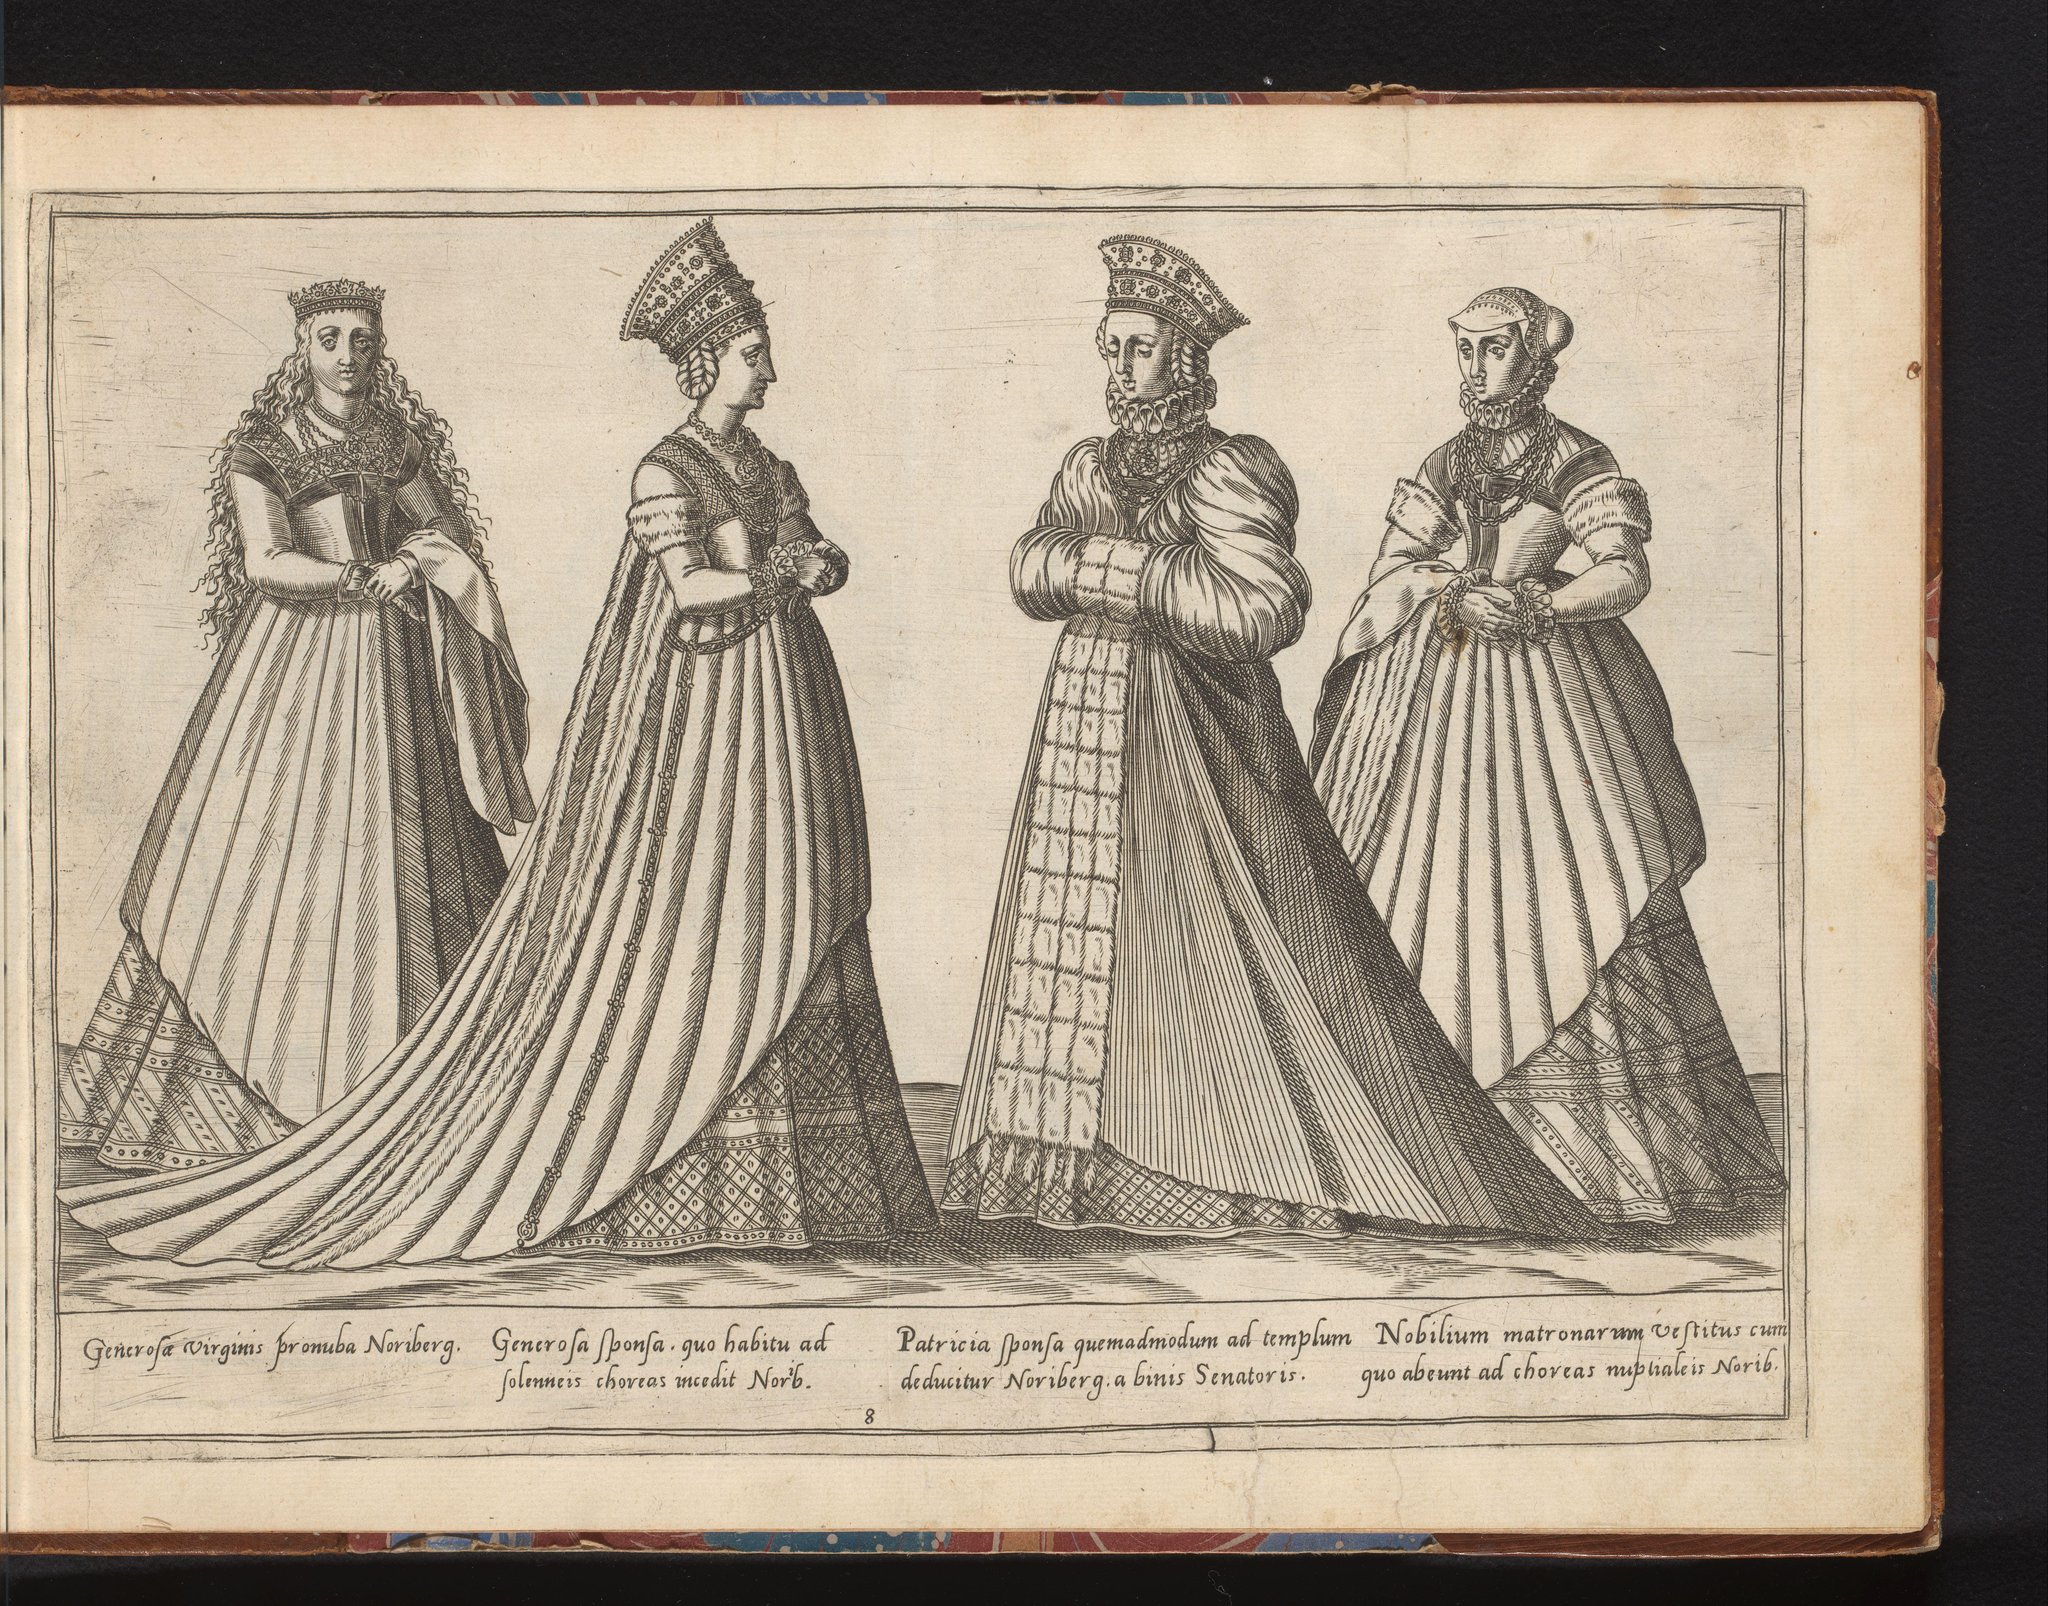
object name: album leaf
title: Vier vrouwen, gekleed volgens de mode uit Neurenberg, ca. 1580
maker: abraham de bruyn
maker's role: print maker, publisher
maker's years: 1540-1587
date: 1581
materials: paper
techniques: engraving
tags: europeans: germans (+ women), europeans: germans (+ costume)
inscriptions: number: ‘8’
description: Prent uit het boek 'Omnium pene Europae, Asiae, Aphricae atque Americae gentium habitus...', 1581. De prent maakt deel uit van een album.